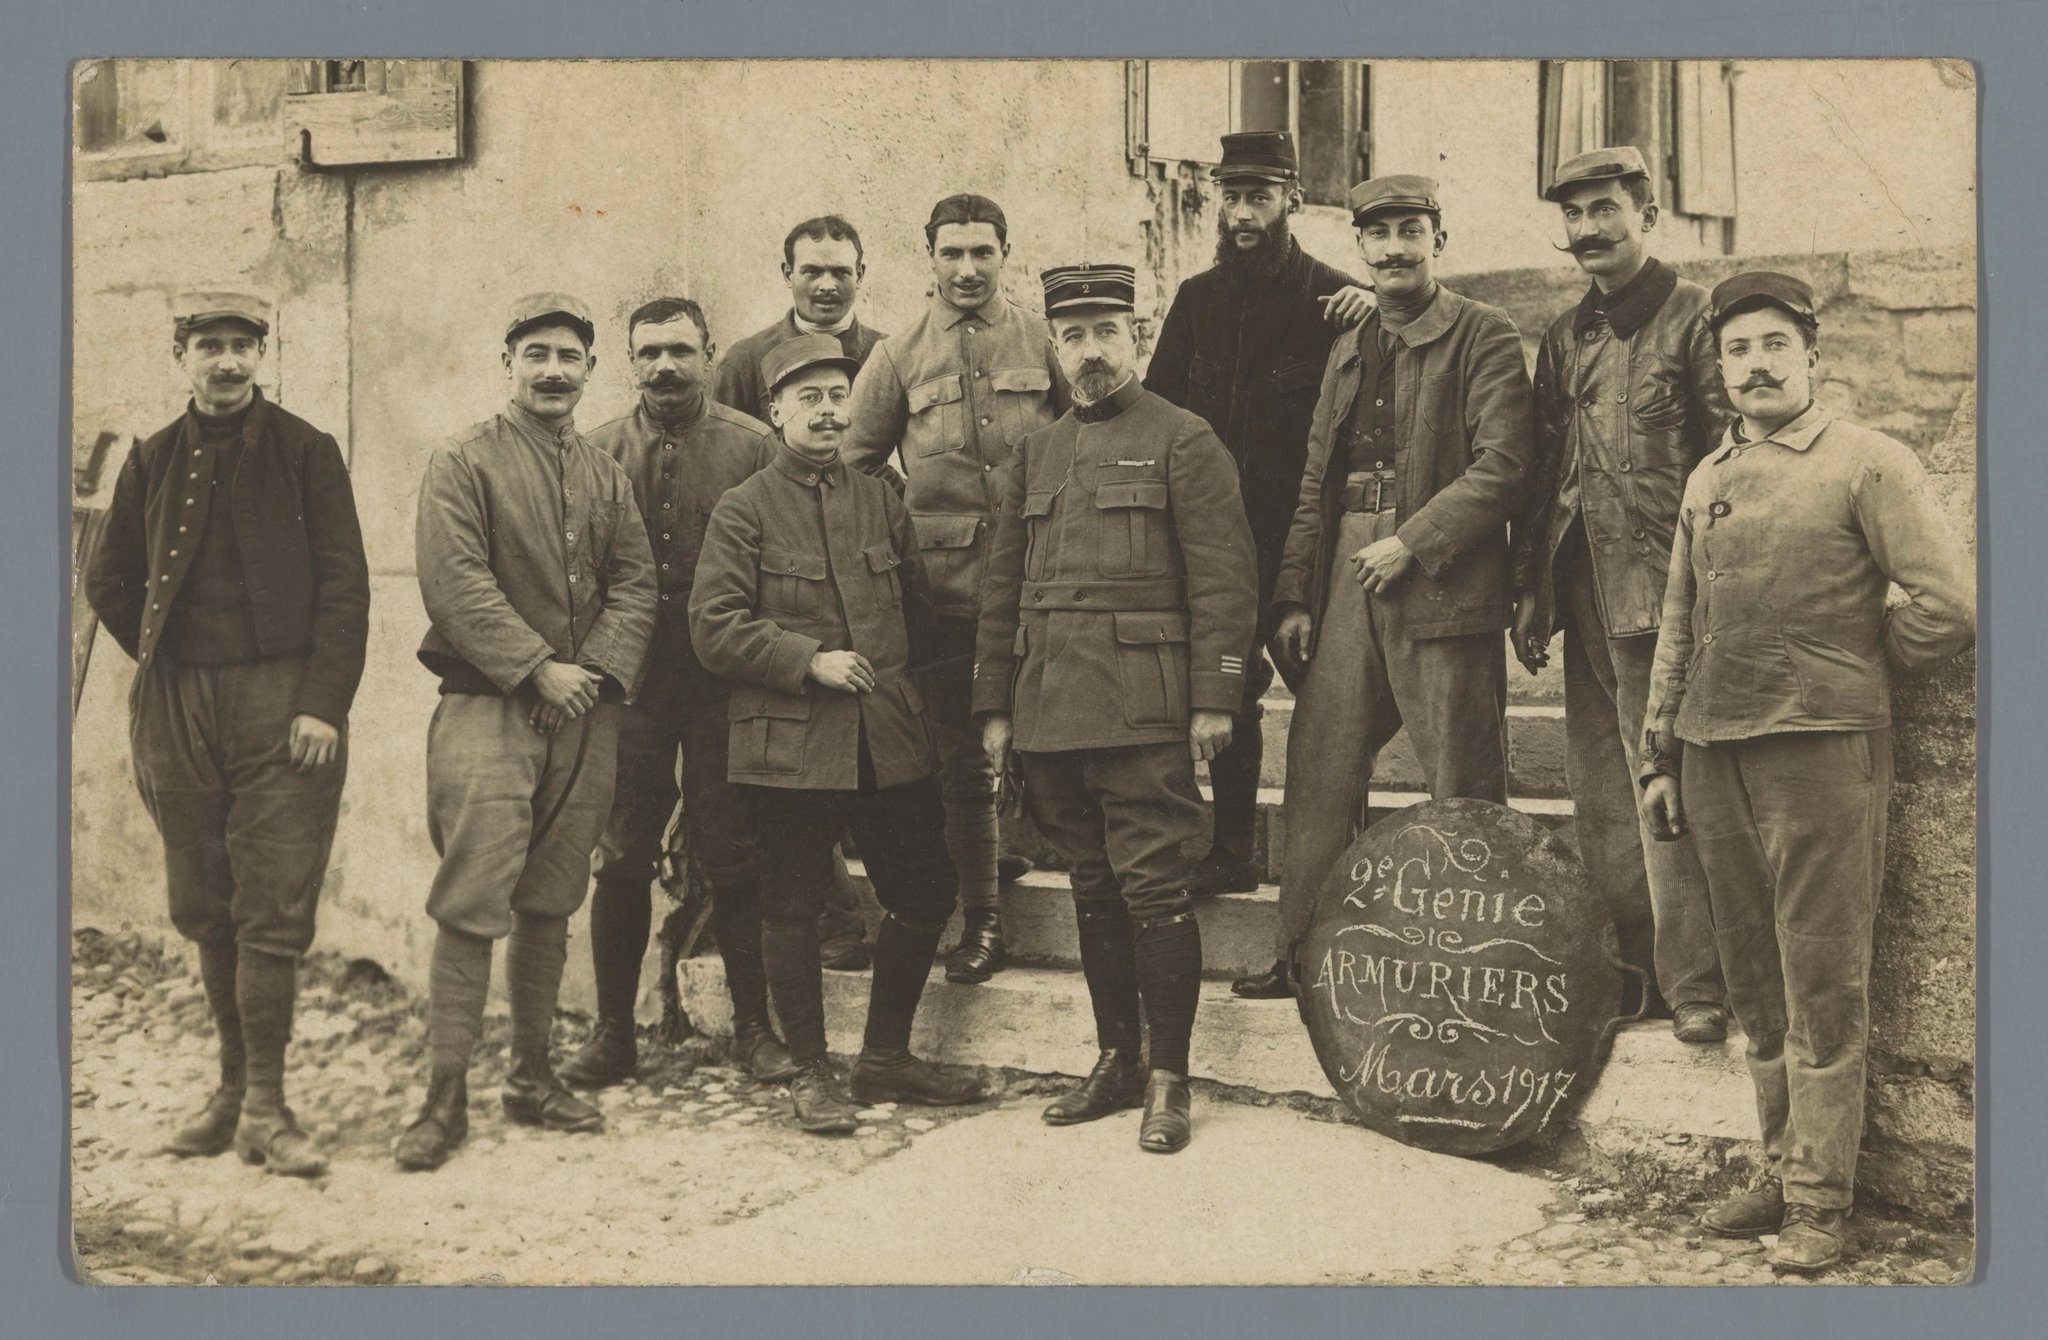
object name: ansichtkaart, prentbriefkaart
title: Groepsportret van (vermoedelijk) wapensmeden van het Deuxième régiment du génie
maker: Anonymous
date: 1903-1917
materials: photographic support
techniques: gelatin silver print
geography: france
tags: gun-smith, rifle-maker, armourer, anonymous historical persons portrayed in a group, in a group-portrait